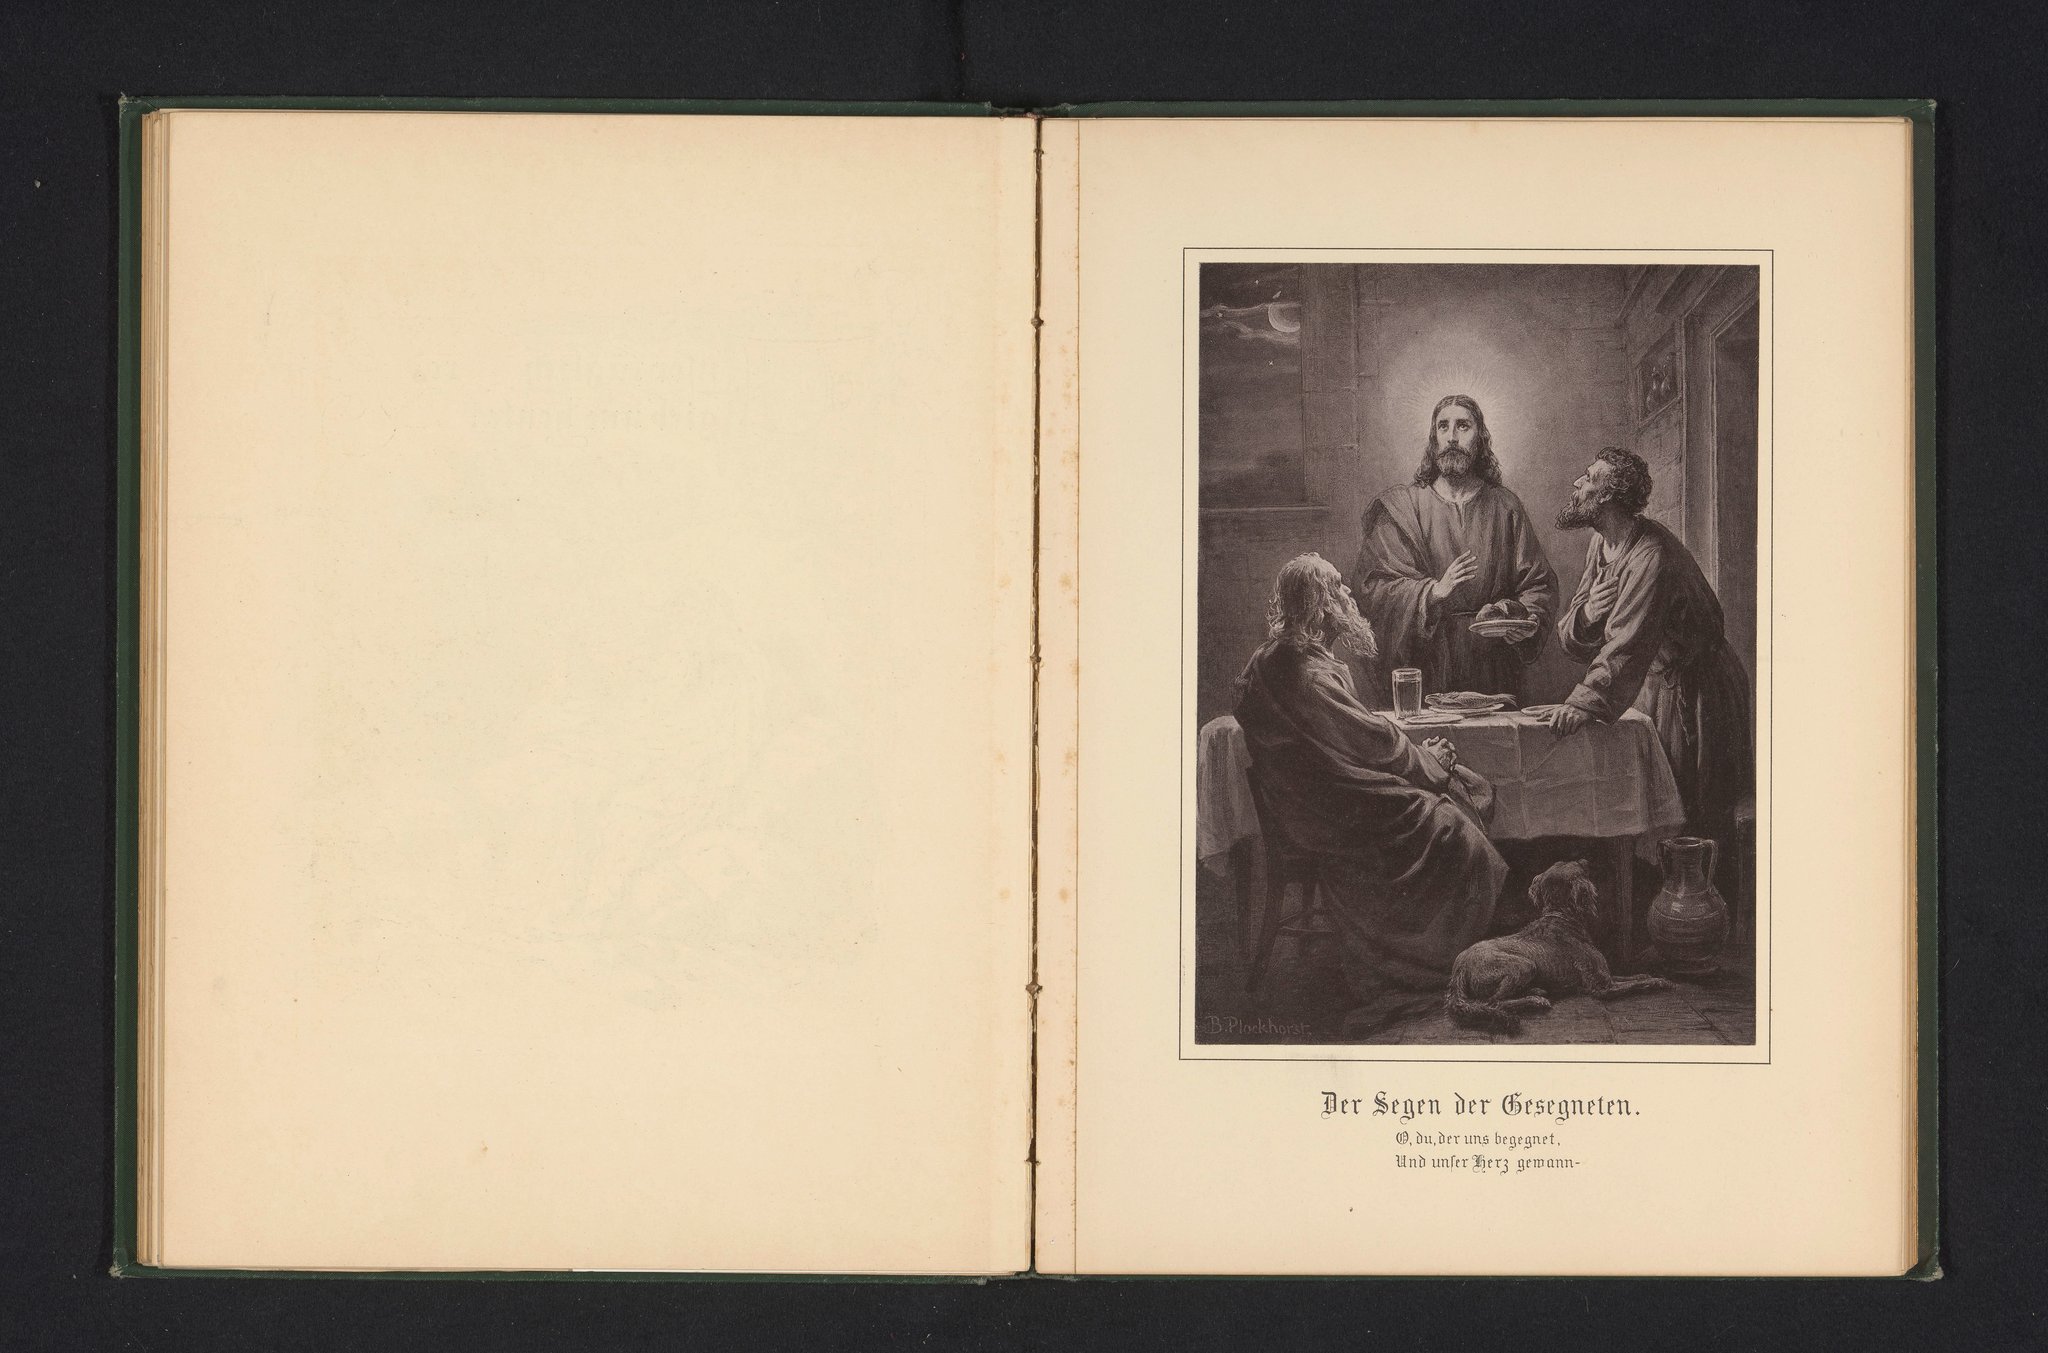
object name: photomechanical print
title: Fotoreproductie van een schilderij van Christus die een maaltijd zegent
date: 1874-1884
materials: paper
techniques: photograph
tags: beatitudes and blessings of christ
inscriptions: inscription: ‘O, du, der uns begegnet, Und unser herz gewann’